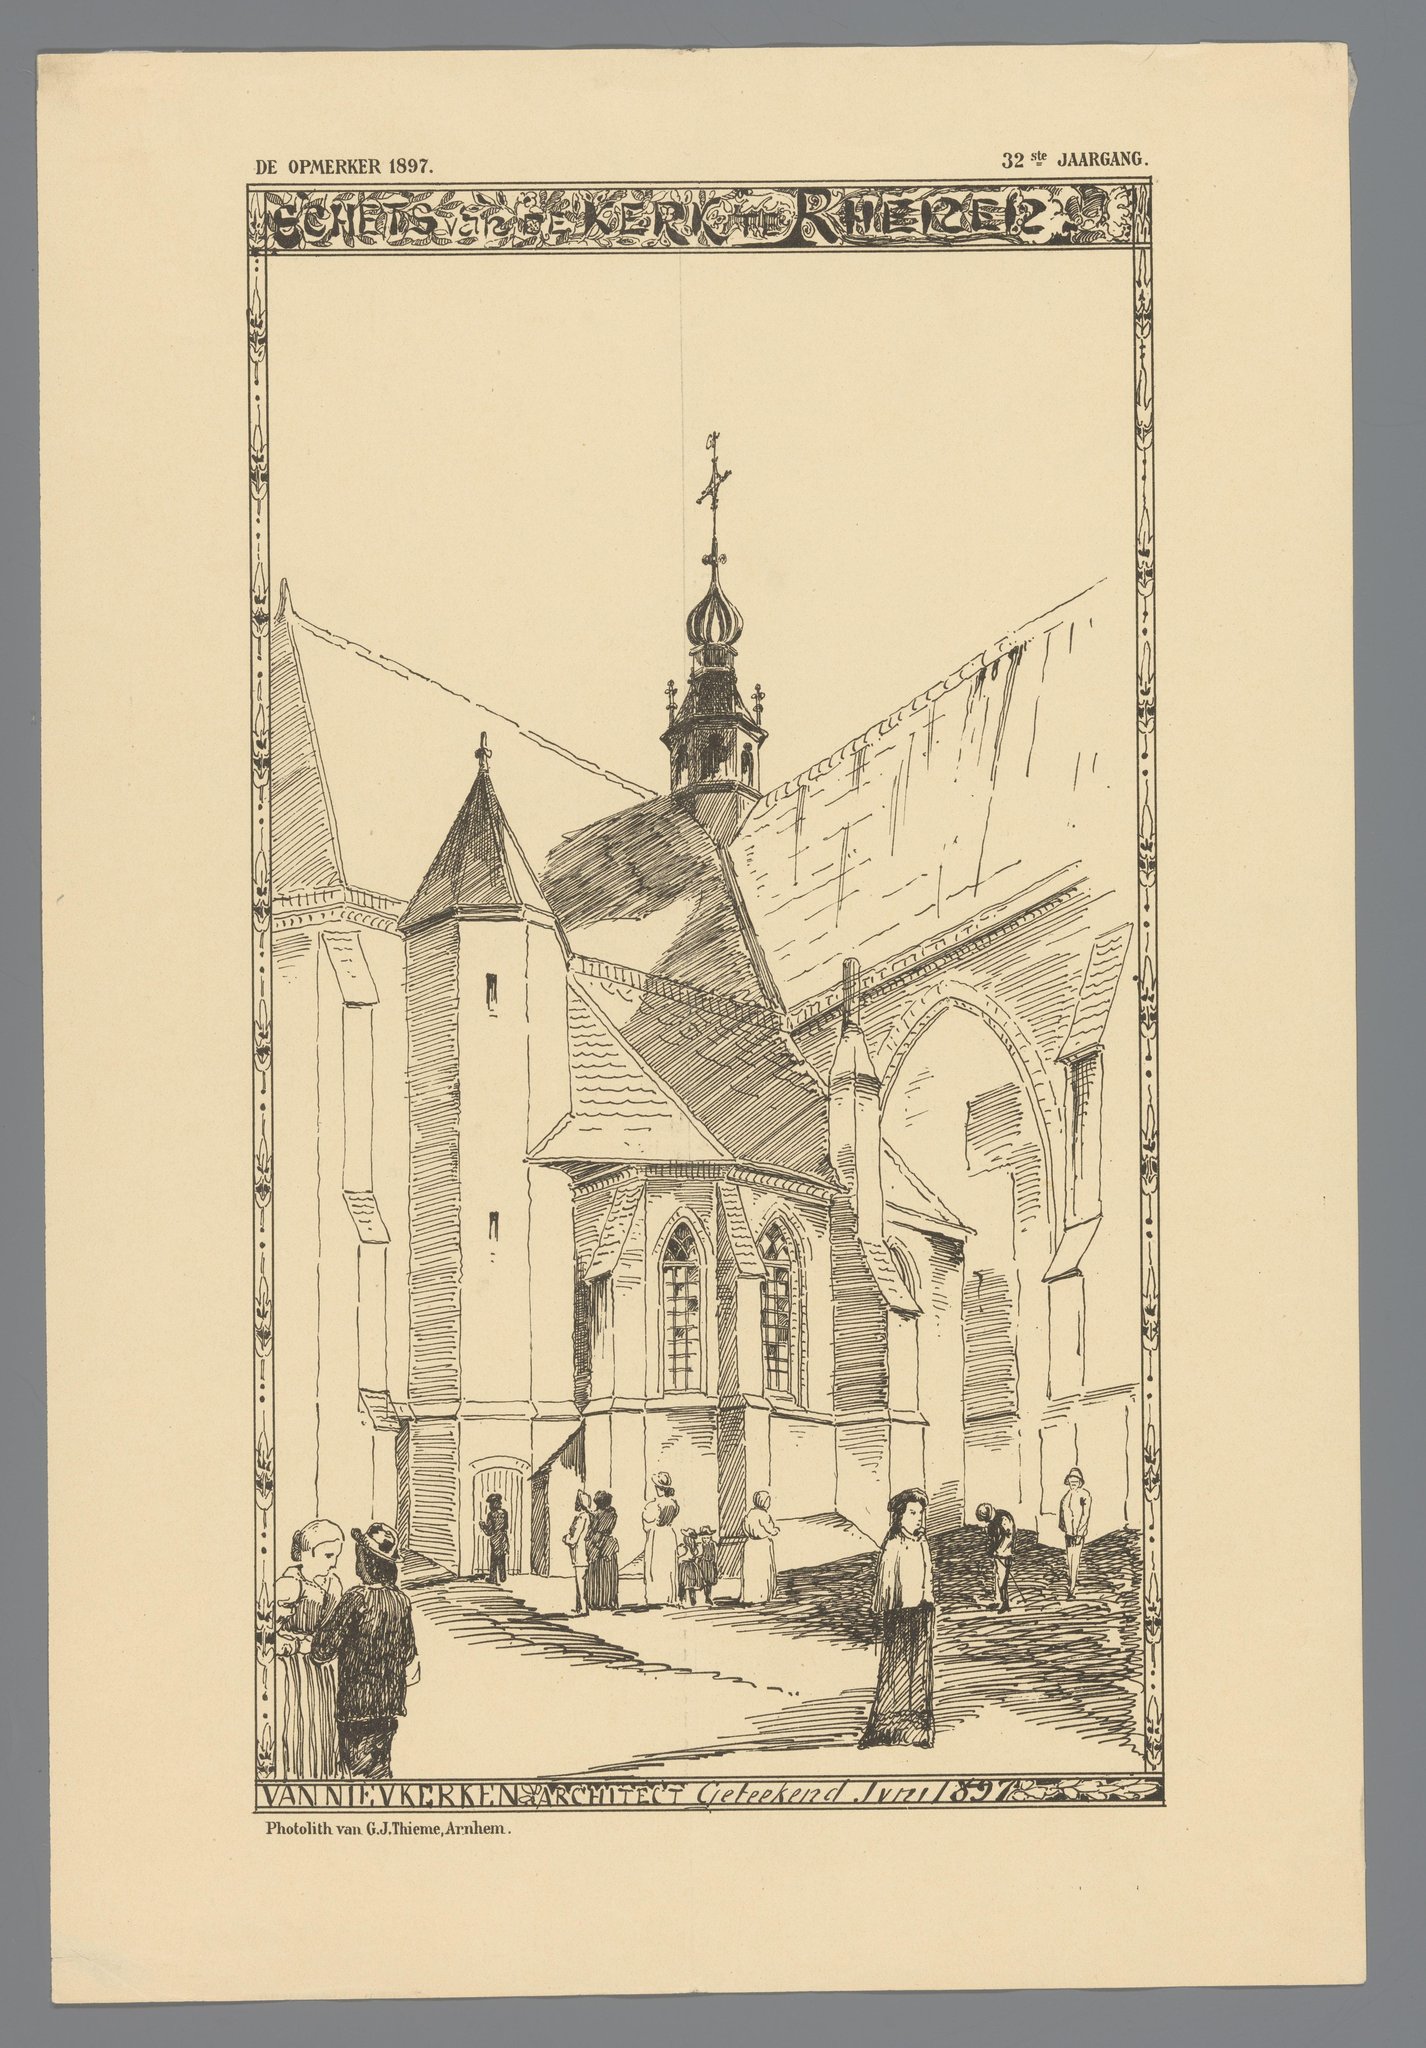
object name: photomechanical print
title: Schets van de kerk te Rhenen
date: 1897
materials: paper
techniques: photolithography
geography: the hague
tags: church (exterior)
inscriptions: date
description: Prent uit: De Opmerker 32 (1897), nr. 42, 16 oktober 1897, p. 336-337.